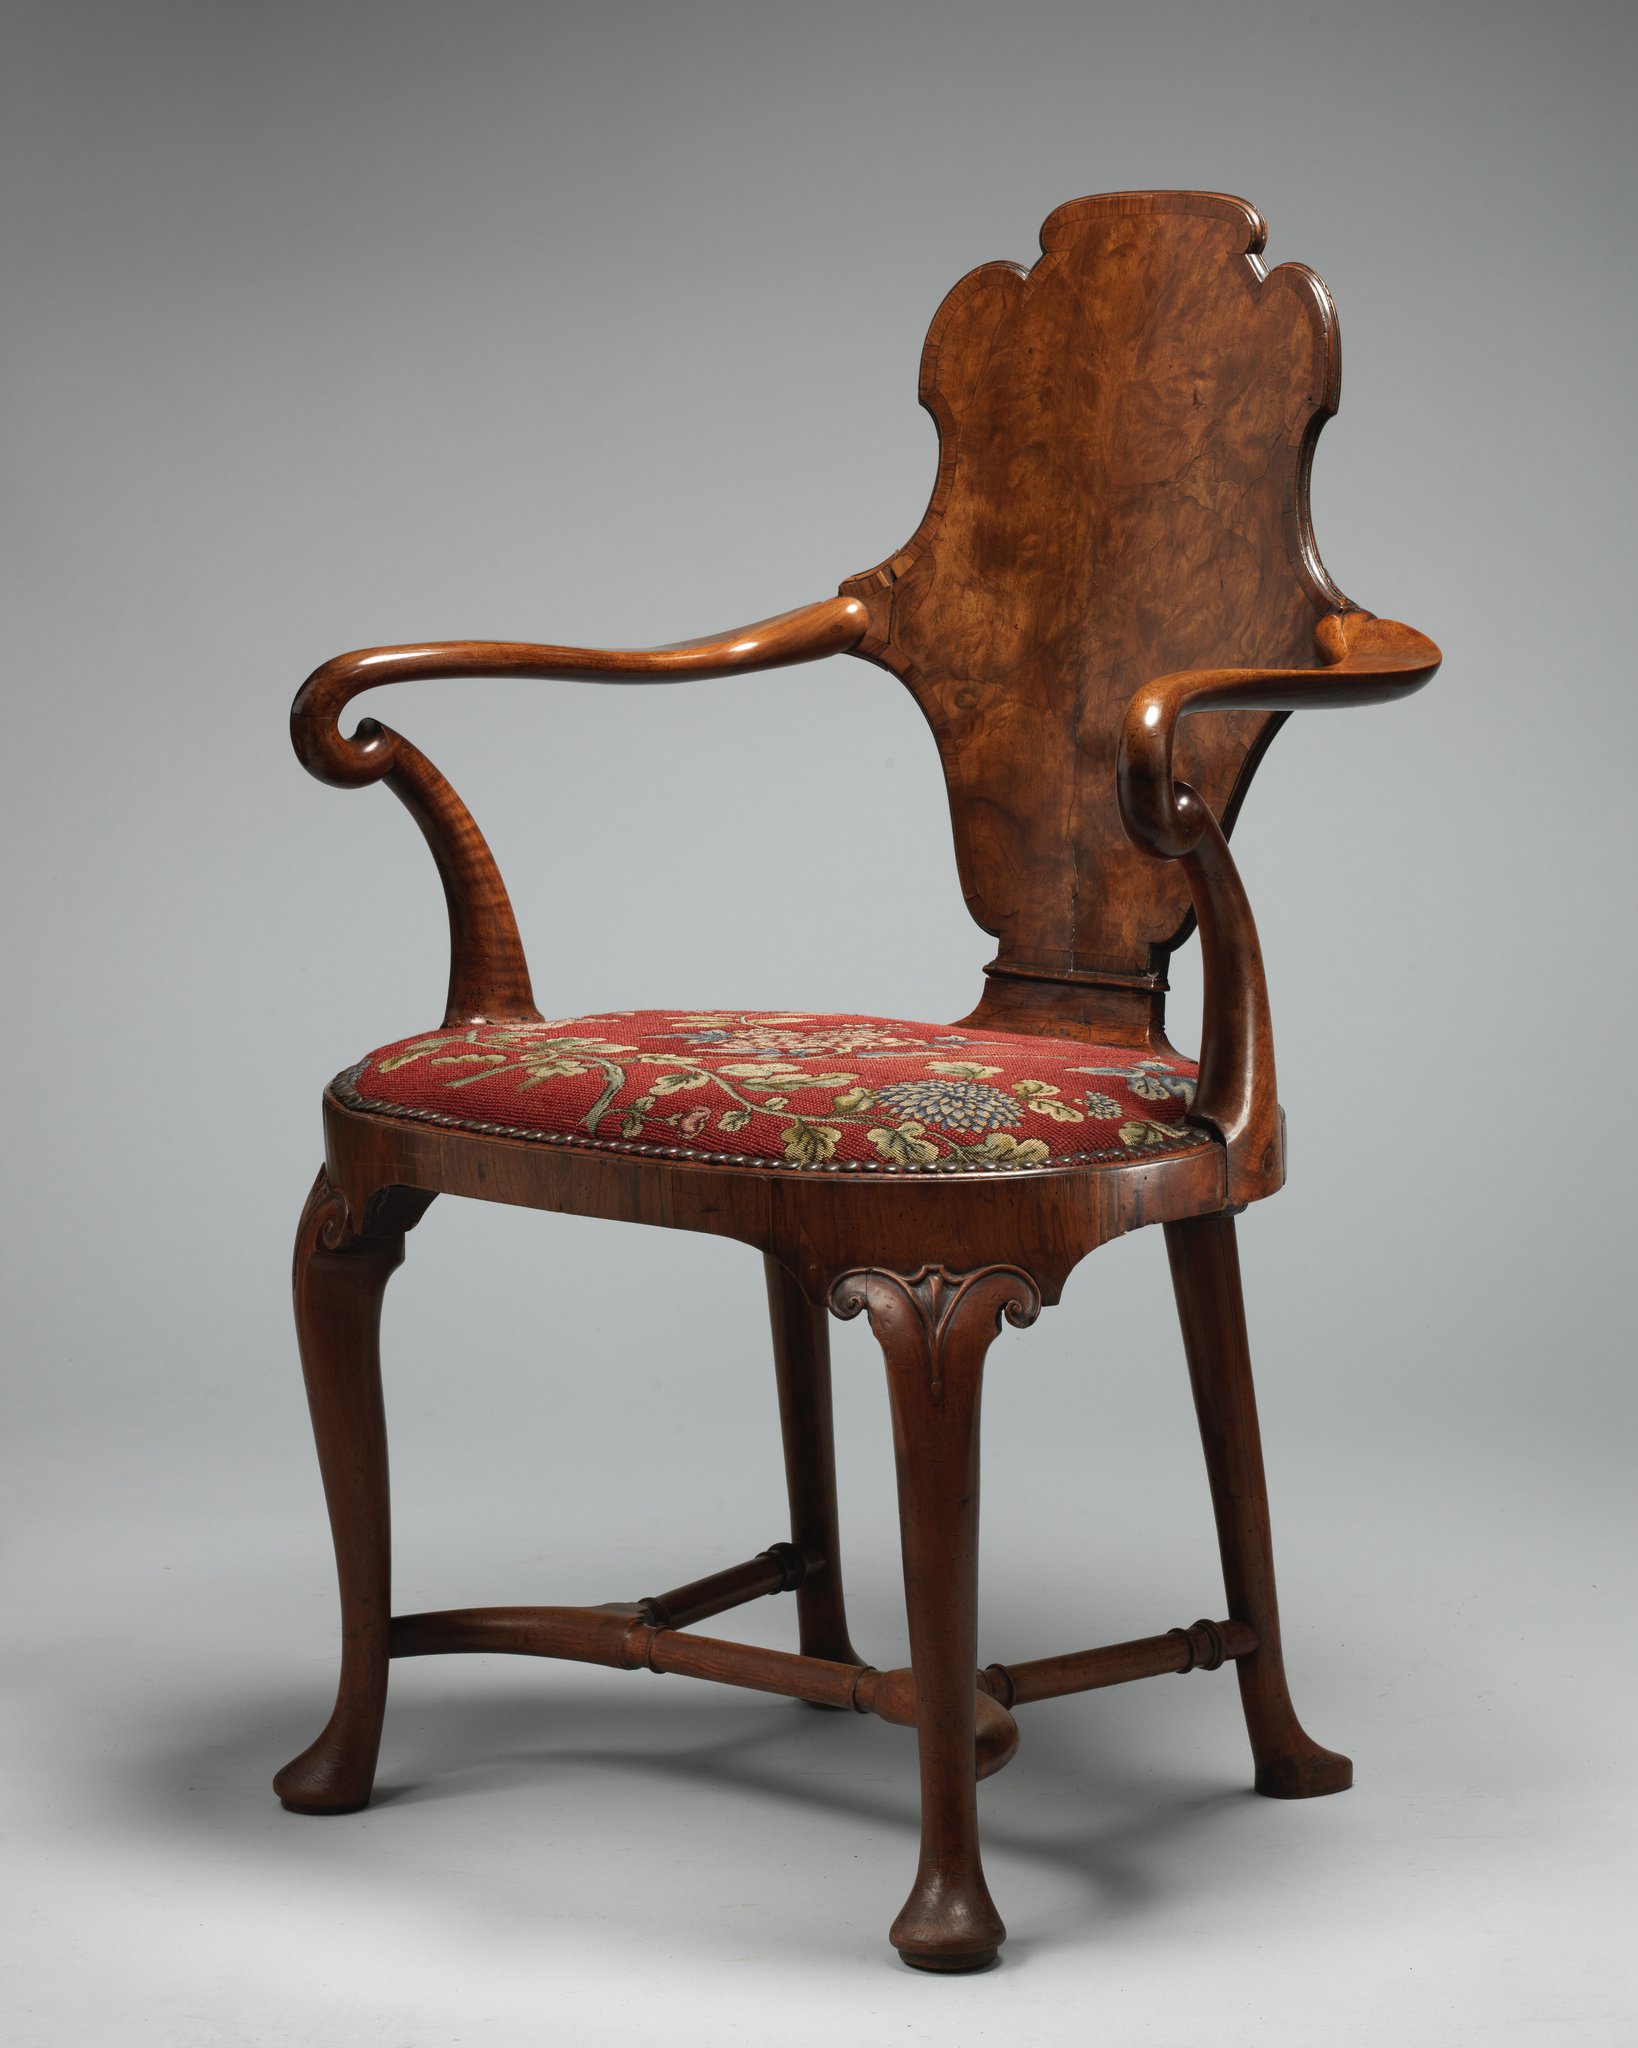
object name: armchair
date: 1710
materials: wood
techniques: veneering